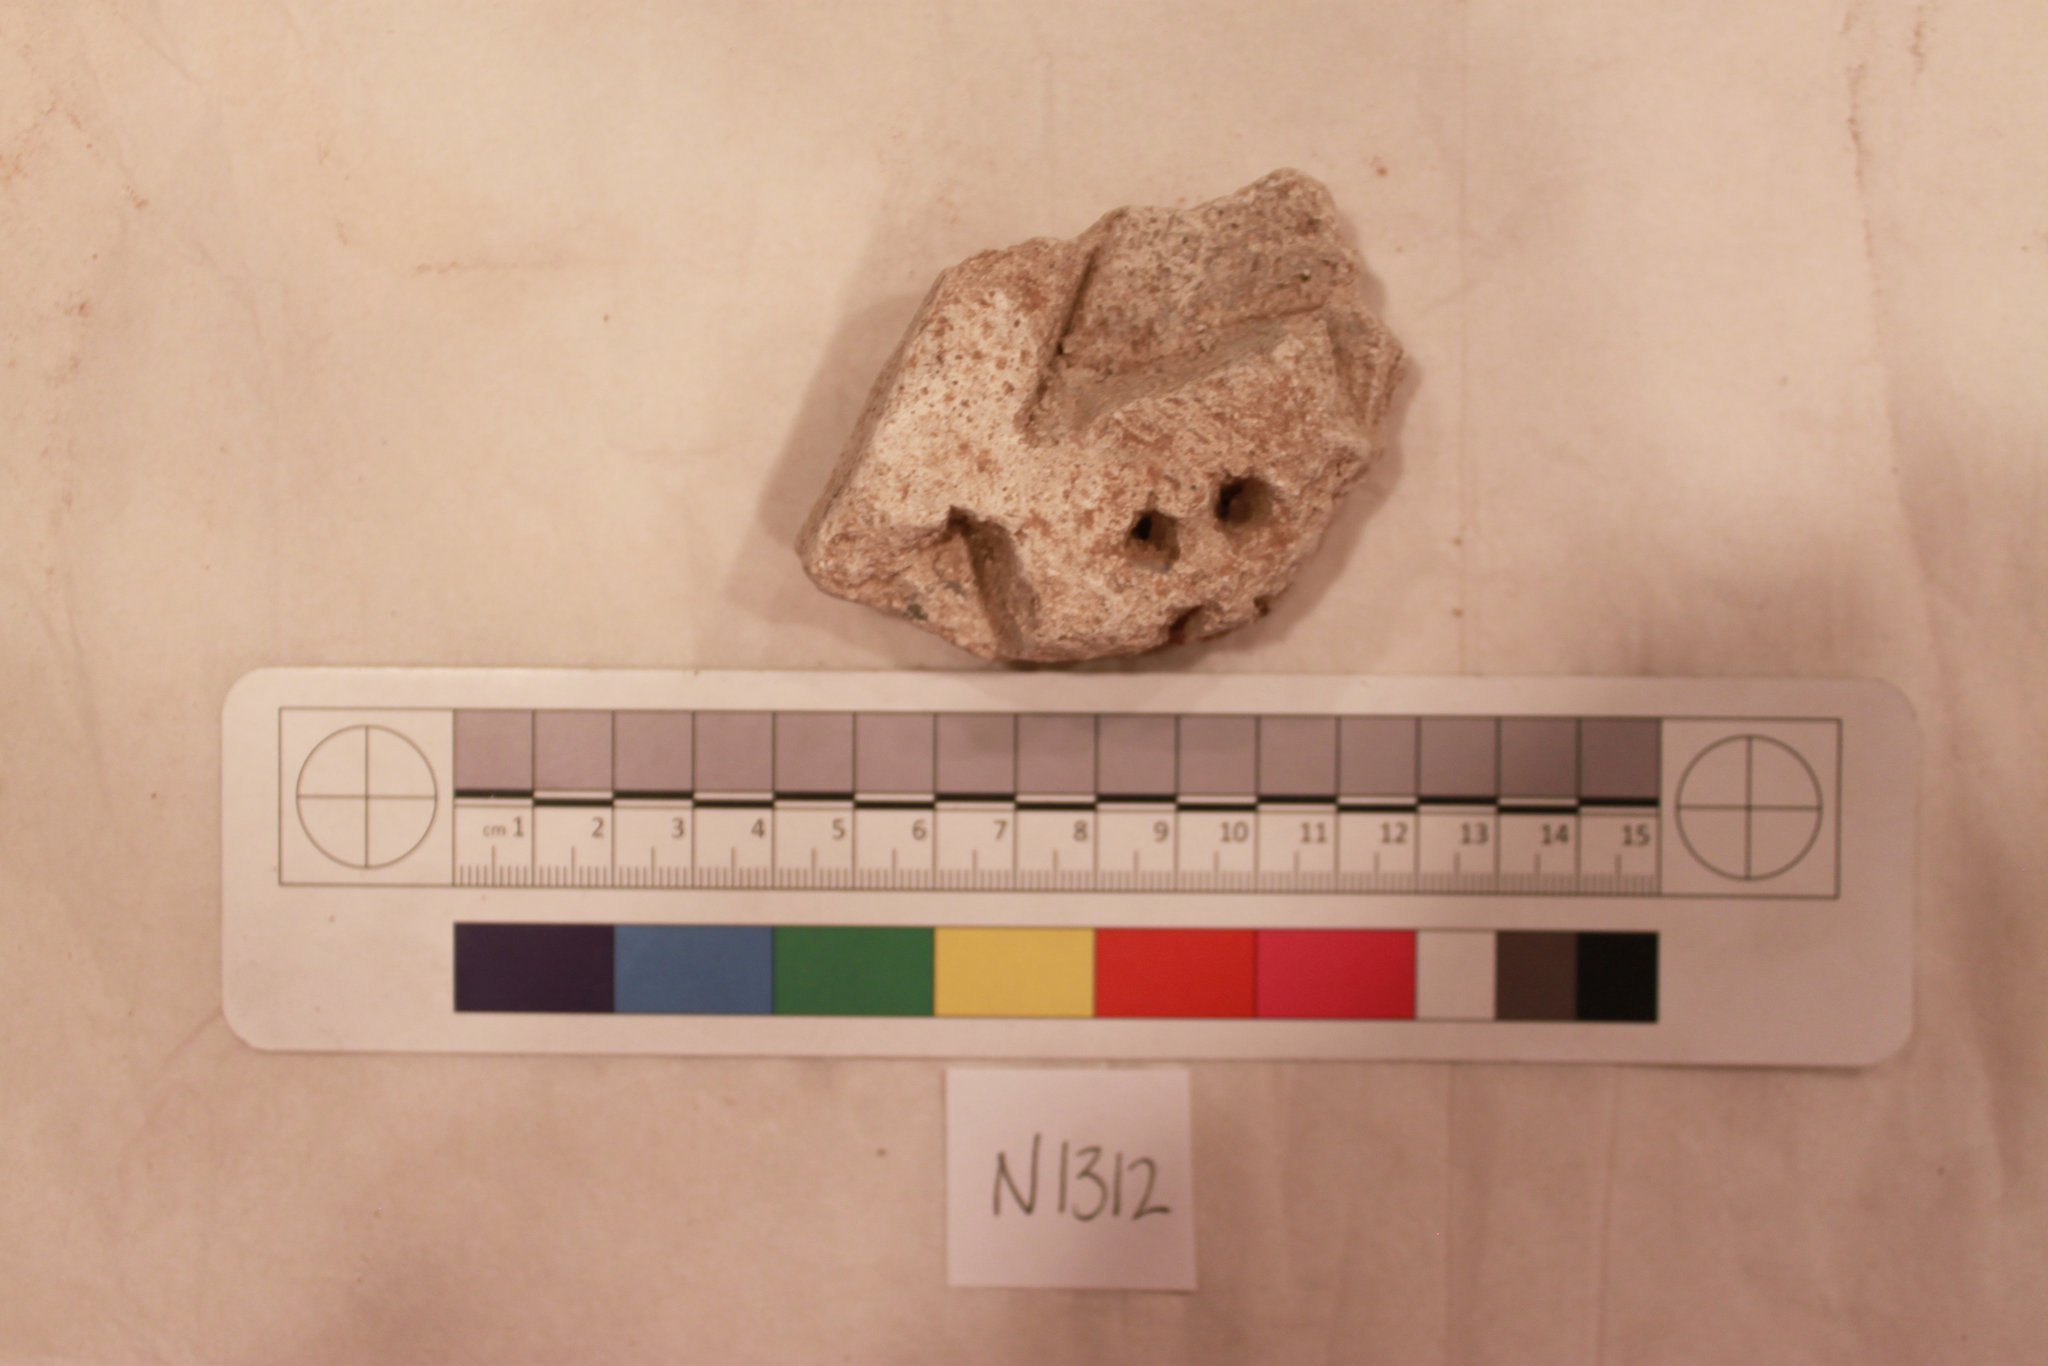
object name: fragment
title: Stucco Fragment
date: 701-1200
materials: plaster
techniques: carving, painting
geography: iran